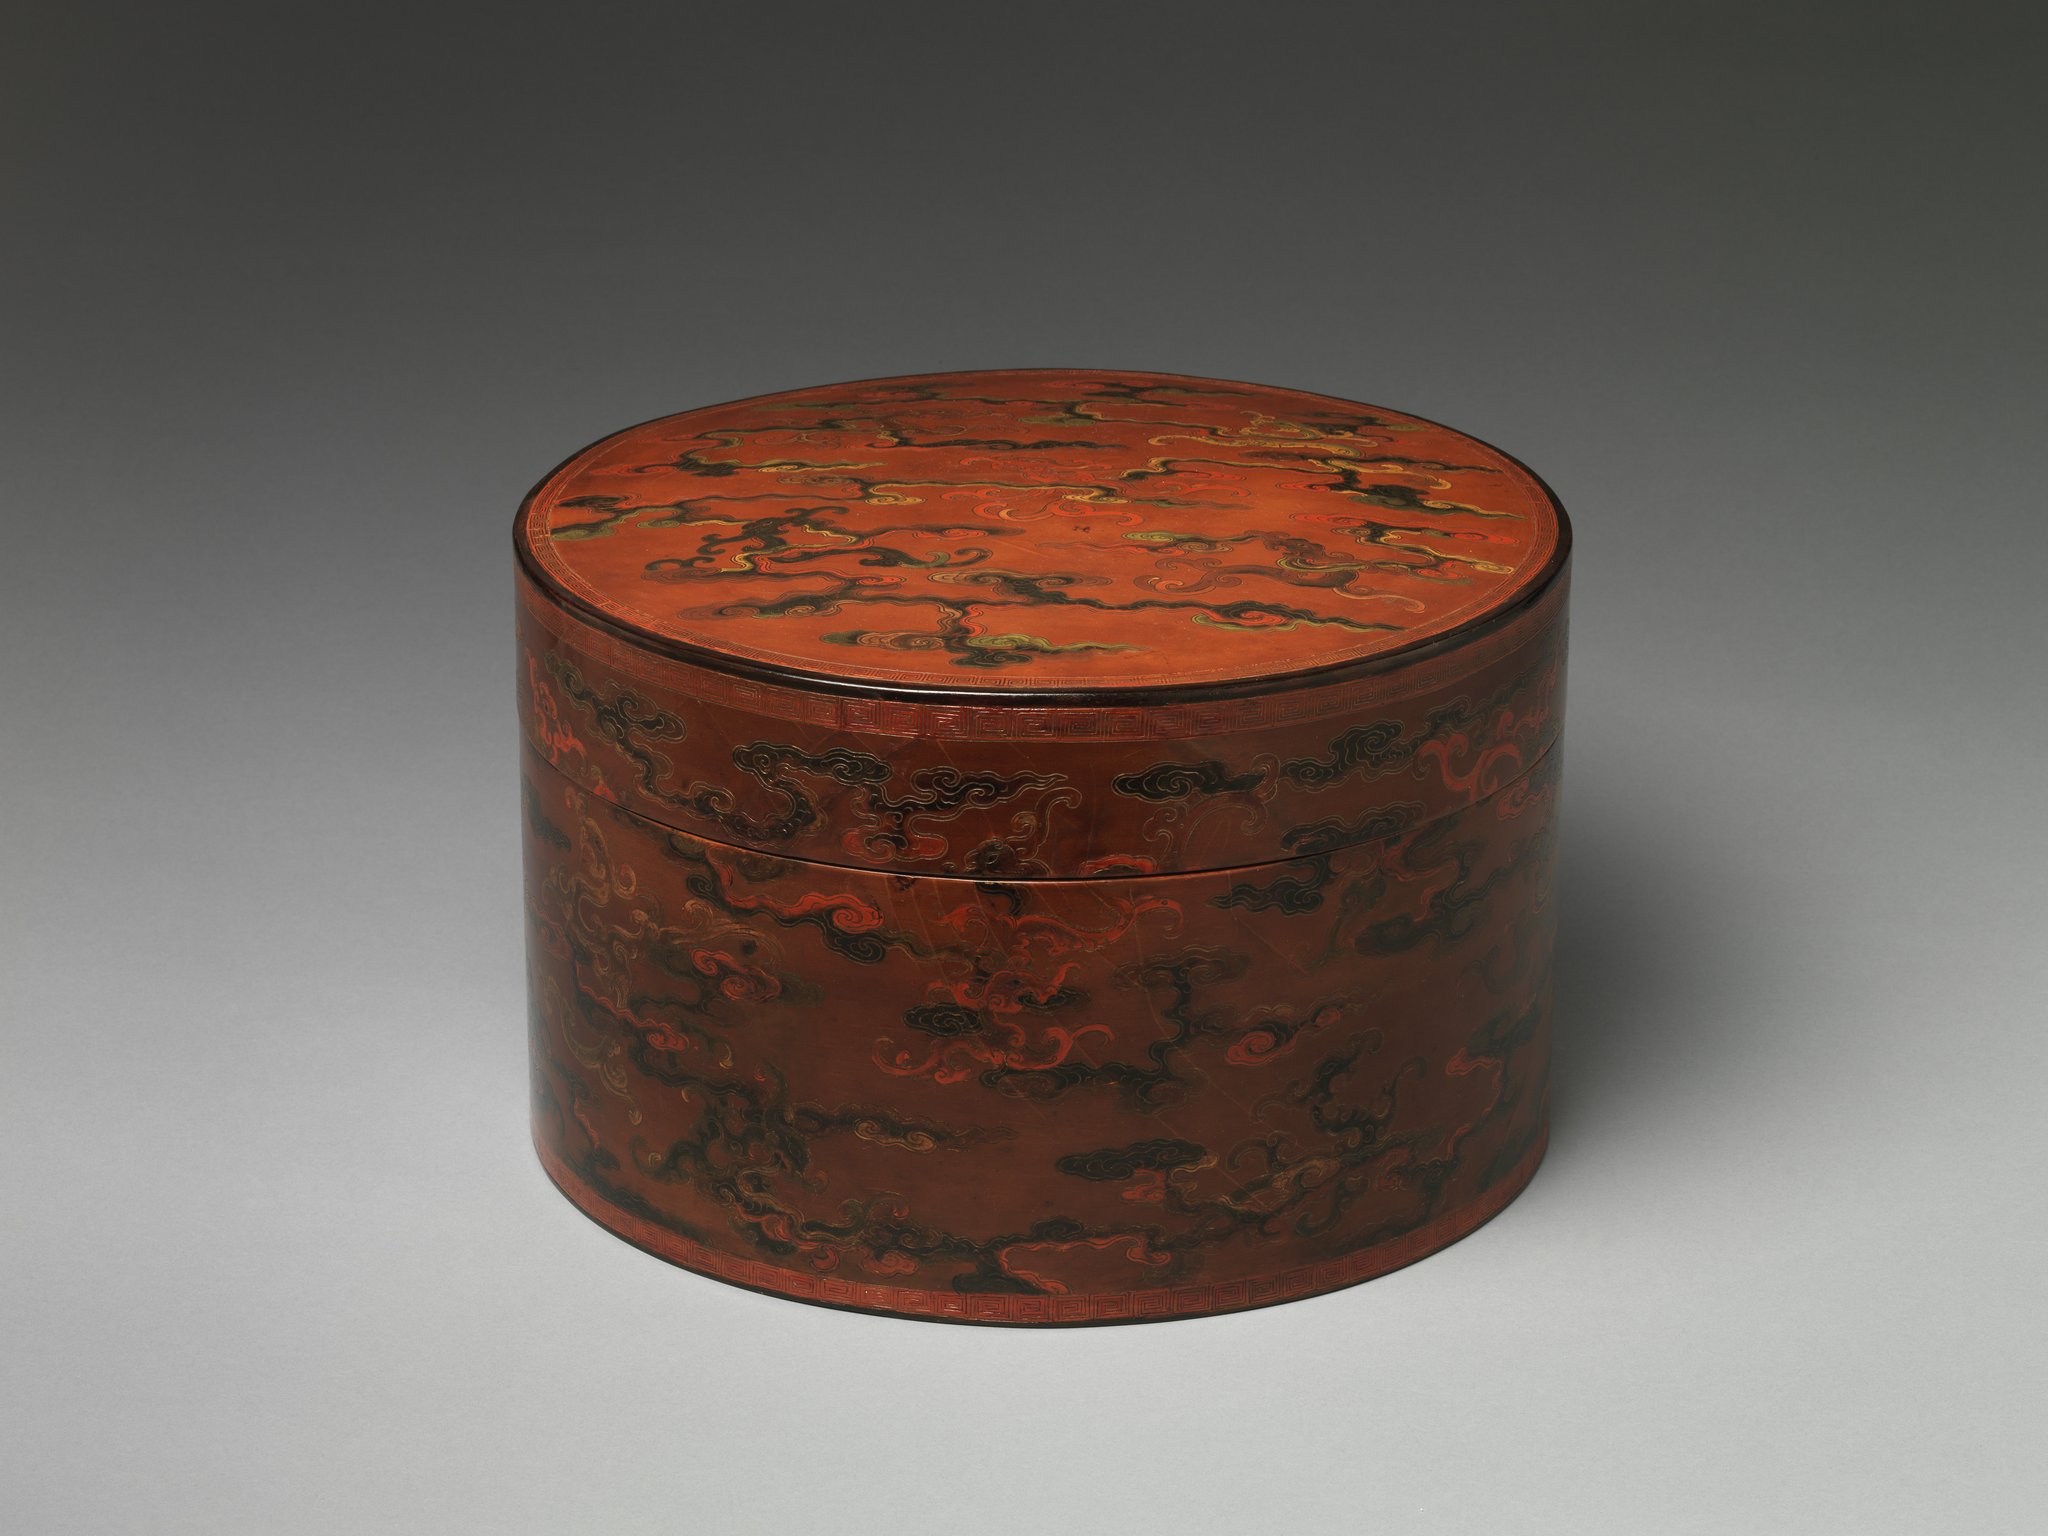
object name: hat box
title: Hat box with stylized chi dragons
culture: chinese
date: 1701-1800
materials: gold, lacquer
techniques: engraving, polychrome